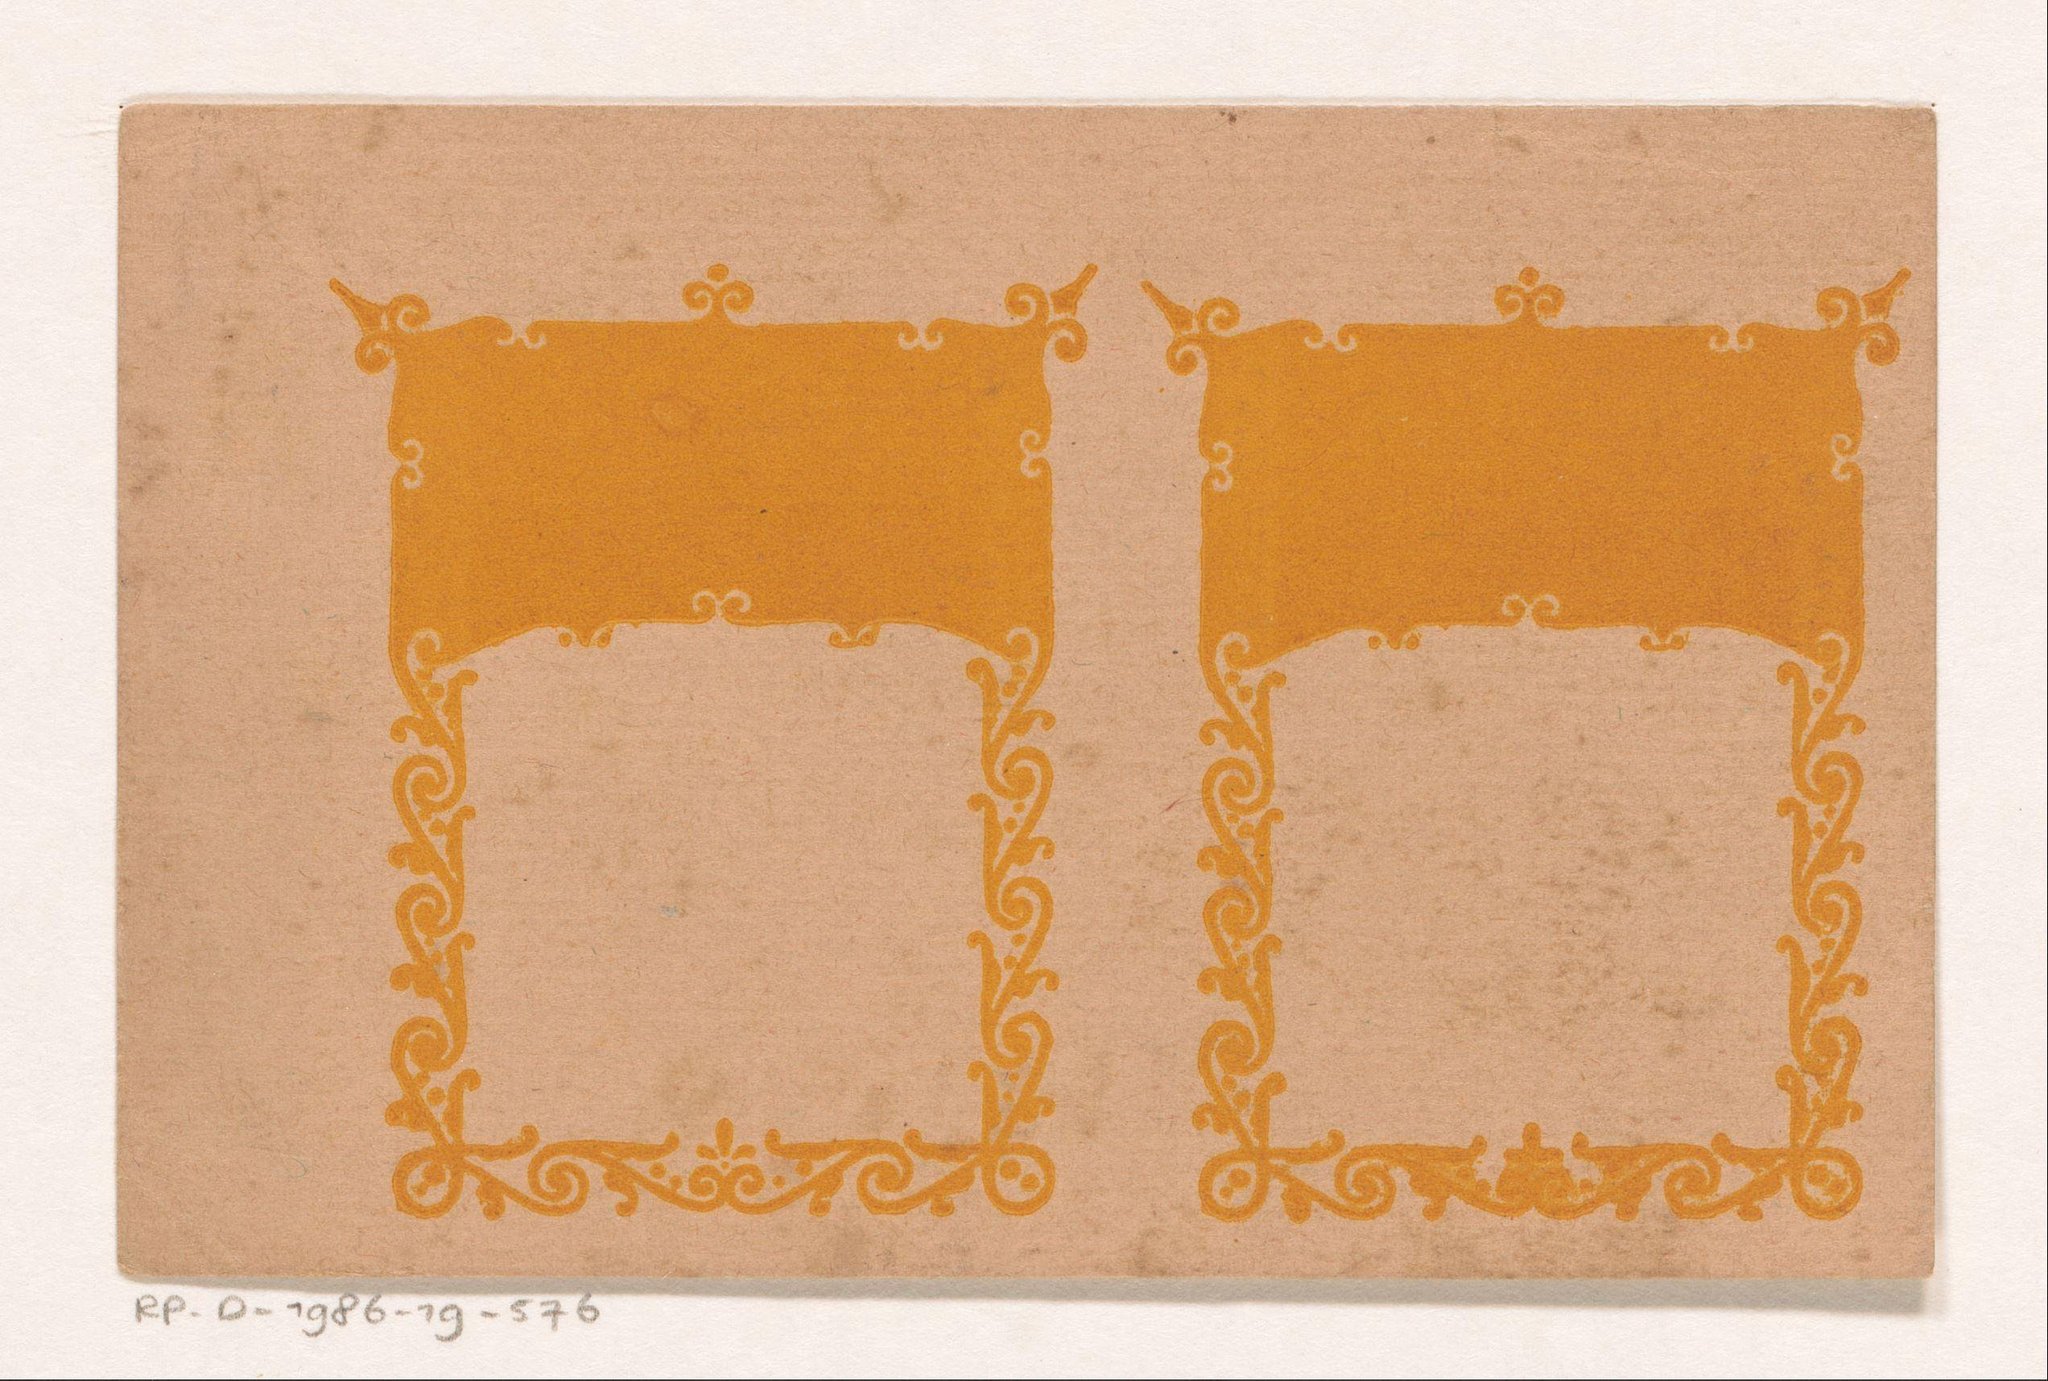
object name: photomechanical print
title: Twee kaders met ornamenten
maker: reinier willem petrus de vries (1874-1953)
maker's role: draughtsman, print maker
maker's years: 1874-1953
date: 1884-1952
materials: paper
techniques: printing block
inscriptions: collector's mark: ‘R:MVS.’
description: De kaders zijn bedoeld voor advertenties van de Hilversumsche Vereeniging tot bestrijding der tuberculose.